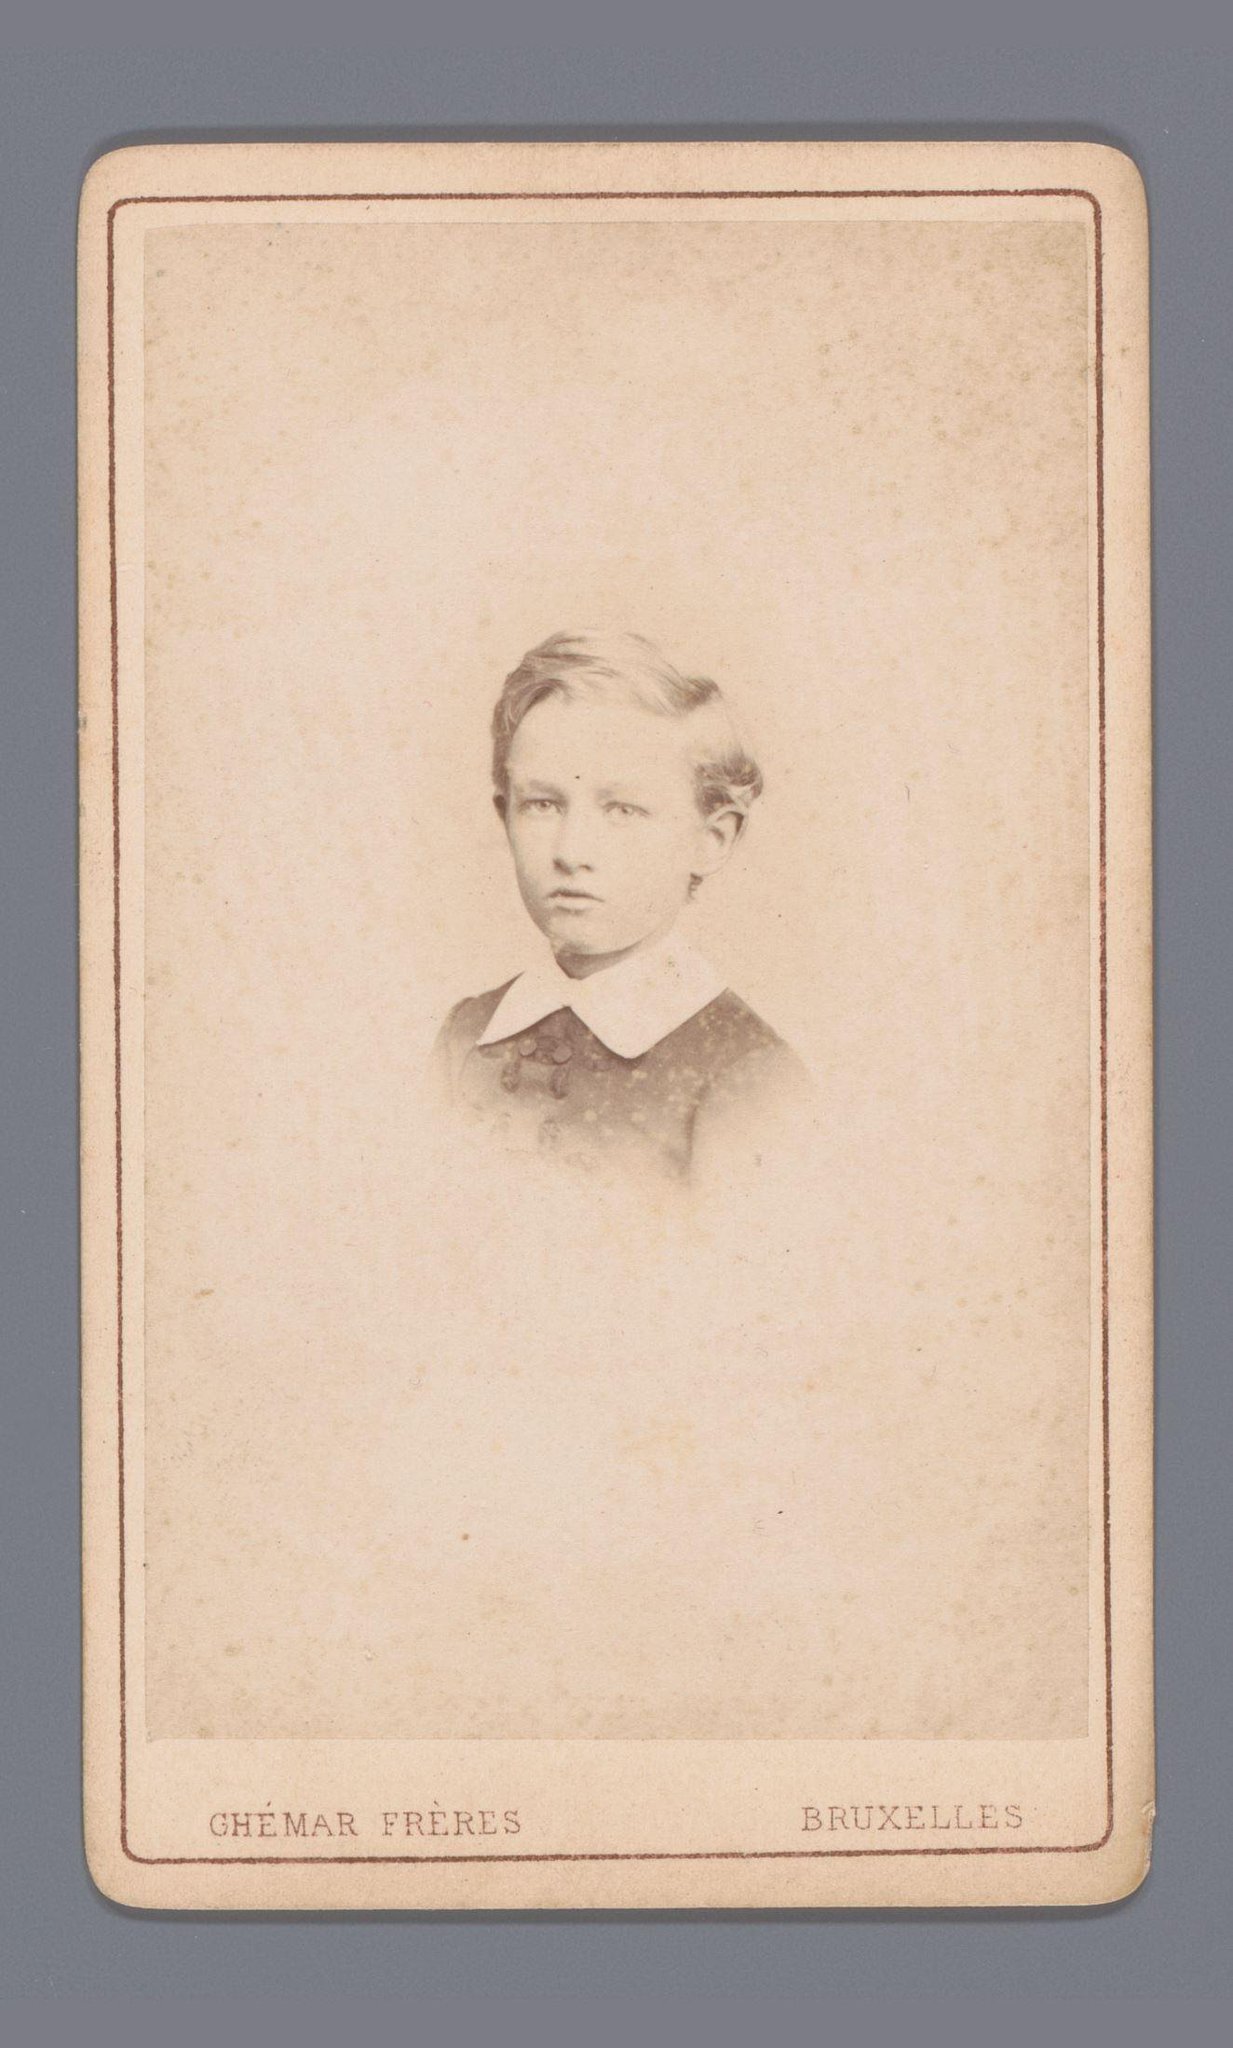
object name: carte de visite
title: Portret van een onbekende jongen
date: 1859-1885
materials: cardboard, paper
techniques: albumen print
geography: brussels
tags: boy (child between toddler and youth), anonymous historical person portrayed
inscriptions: address: ‘27, Rue de l'Ecuyer, 27,/ Entrée par la porte cochère/ BRUXELLES’, inscription: ‘Les Clichés sont conservés indéfiniment.’